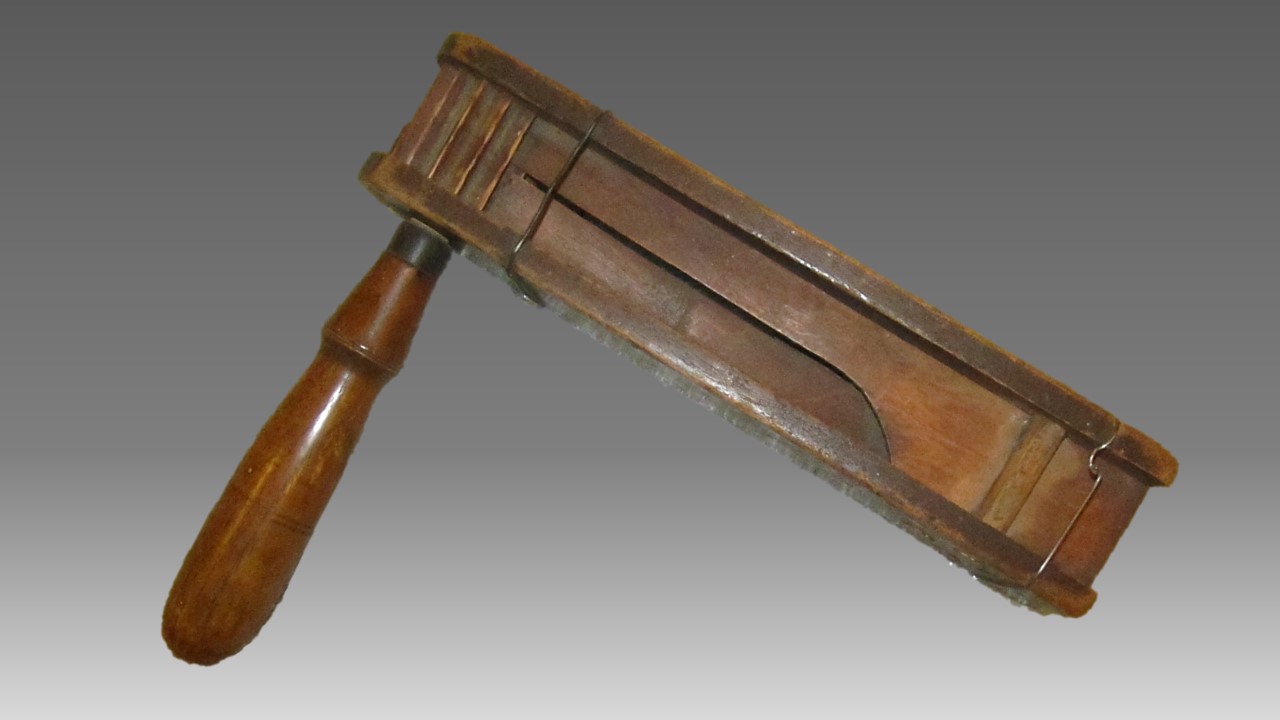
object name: ratchet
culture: american or english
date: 1767-1866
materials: wood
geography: united states